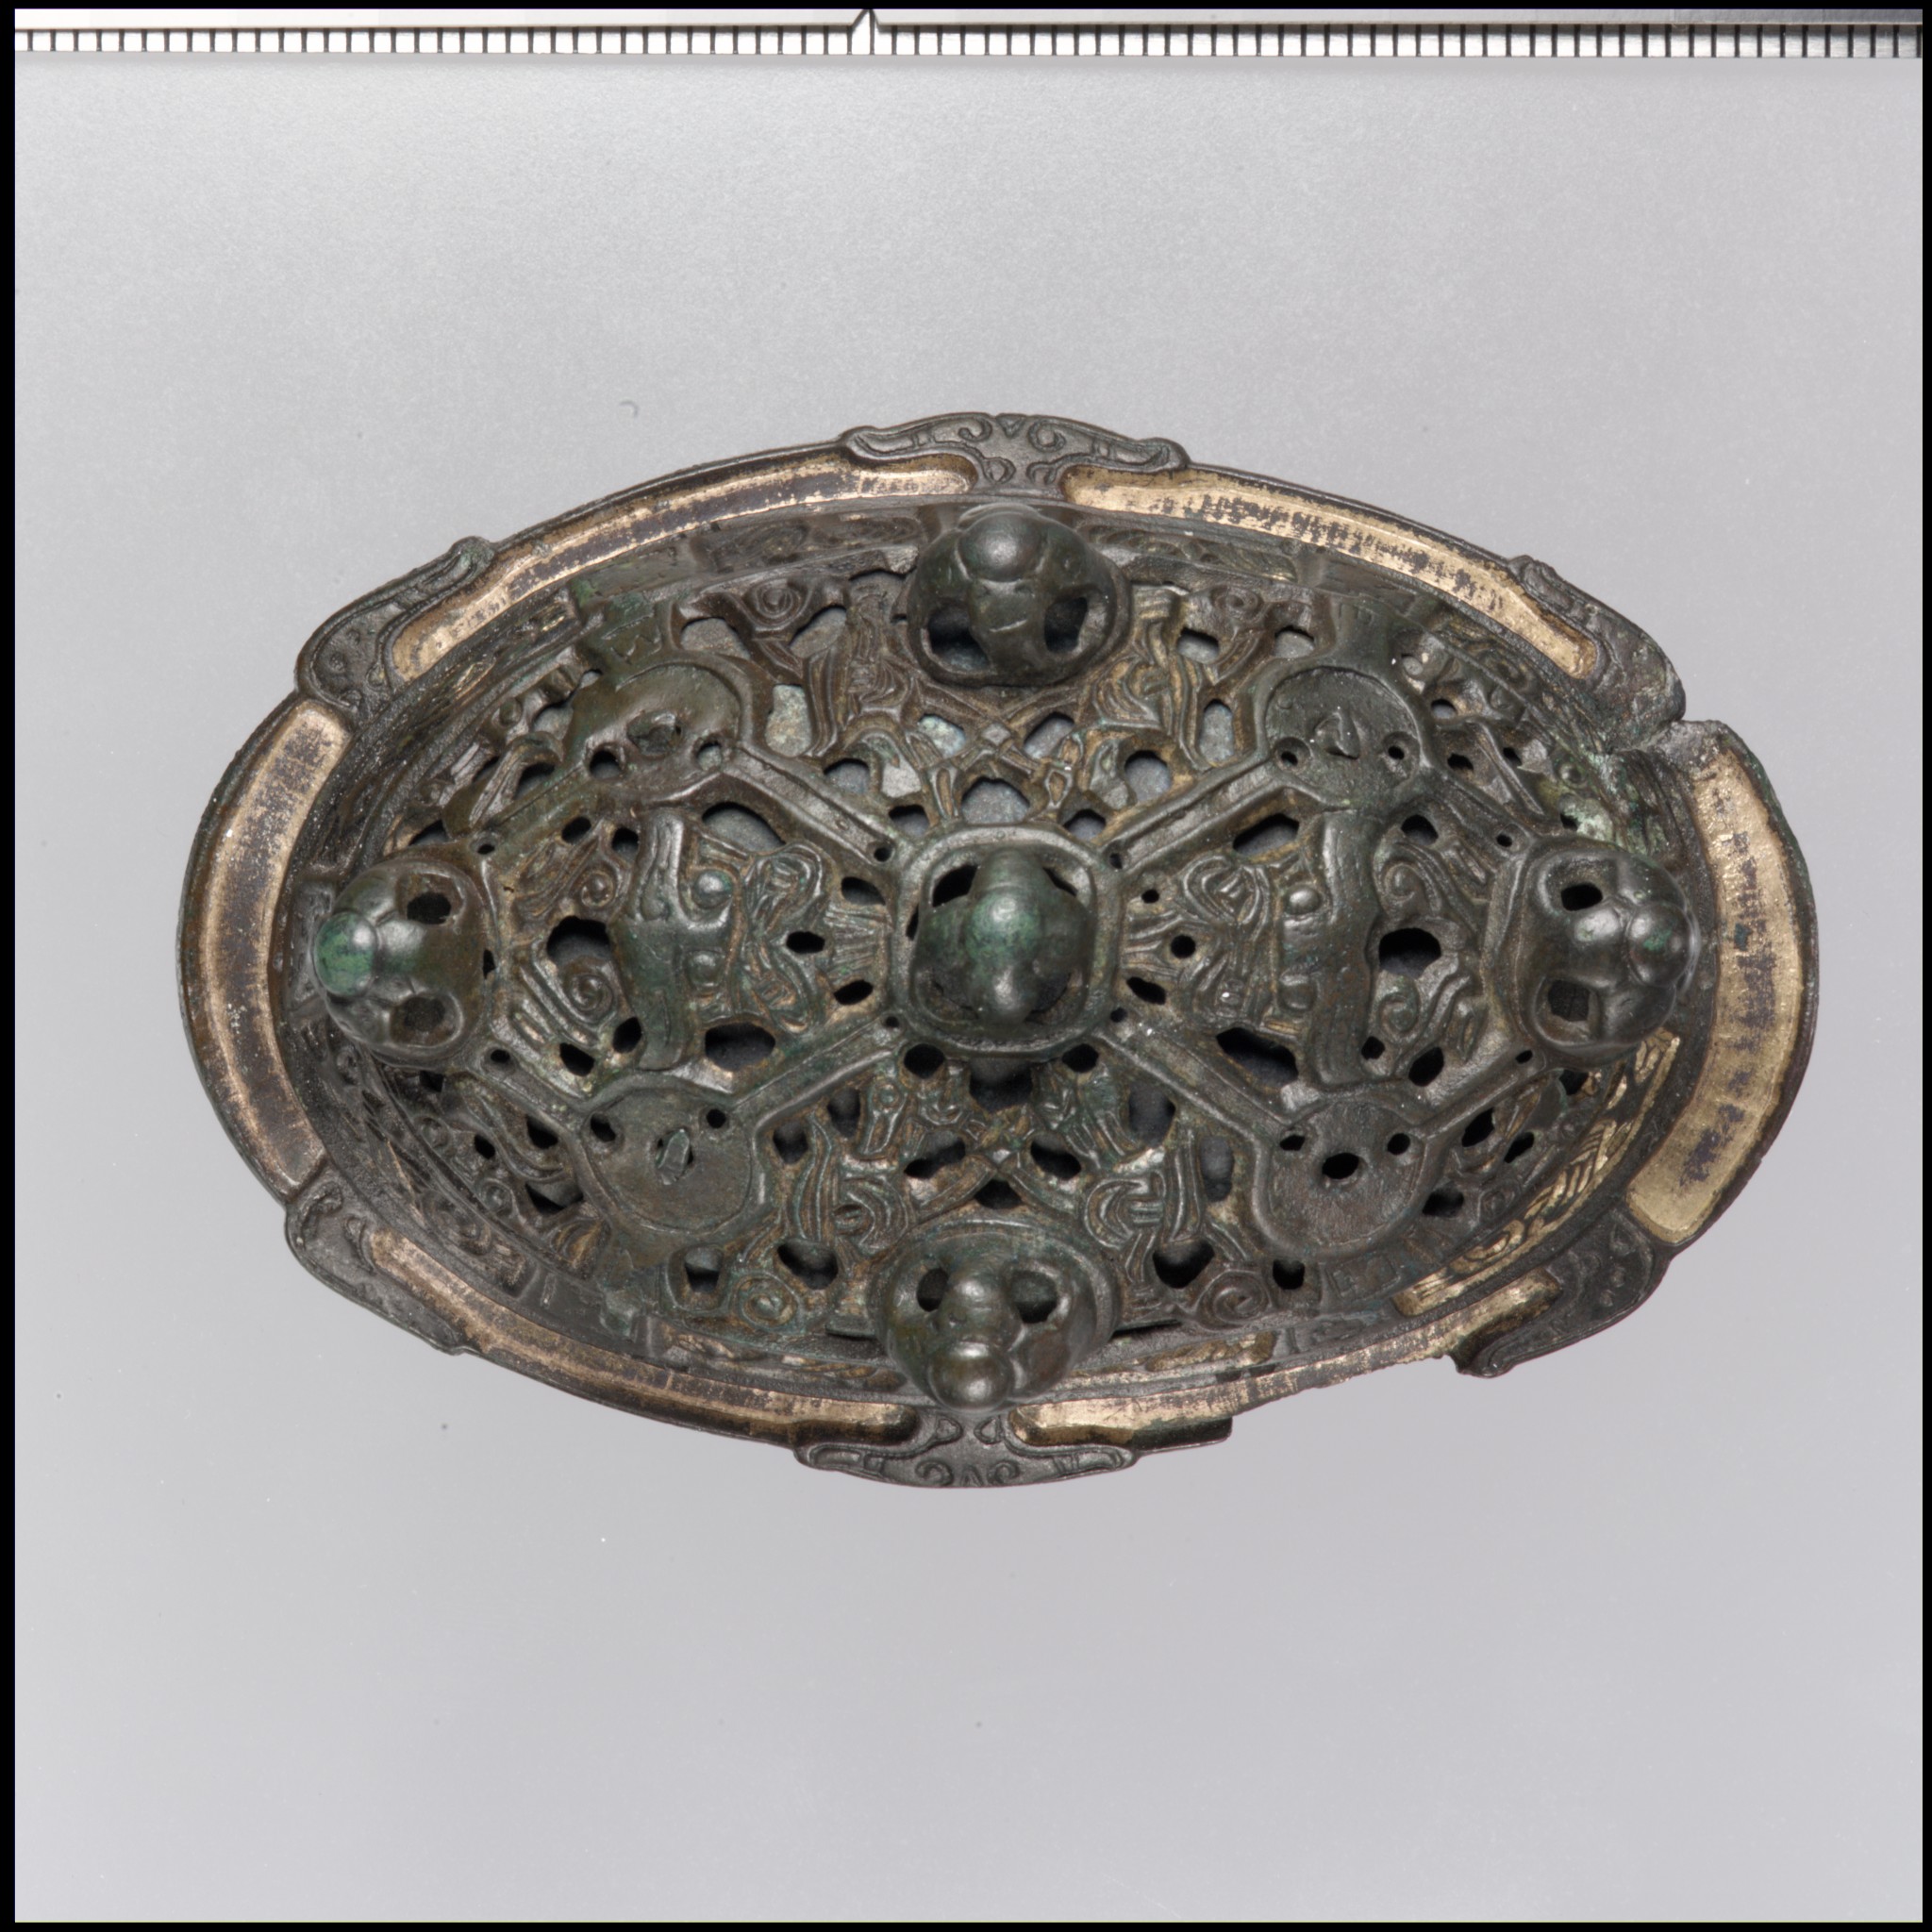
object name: brooch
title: Oval Brooch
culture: viking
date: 900-1000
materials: copper alloy, gilt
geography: scandinavia